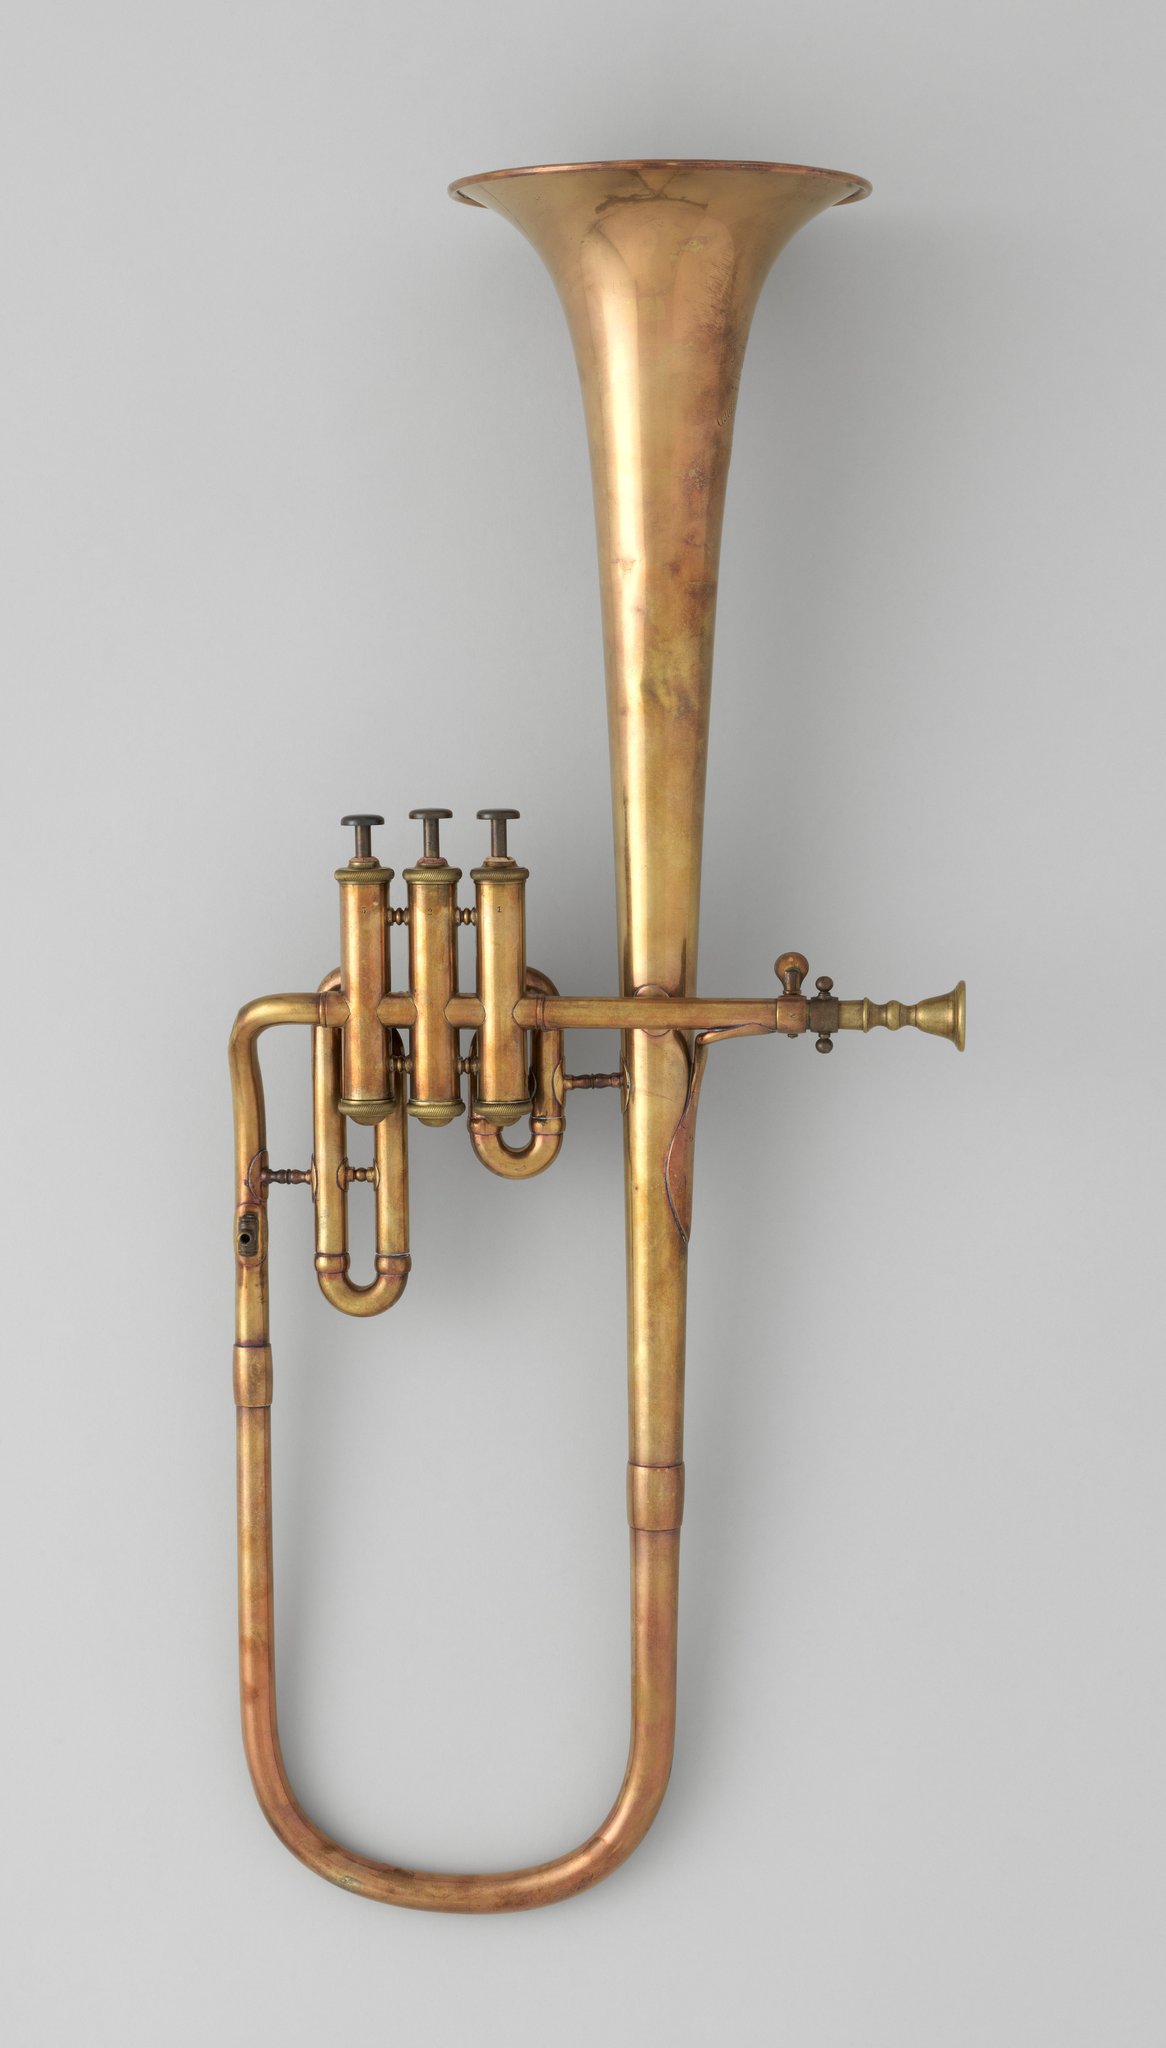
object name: soprano saxhorn in b flat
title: Alto Saxhorn in B-flat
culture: french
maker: gautrot aîné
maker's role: maker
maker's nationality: french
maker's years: 1870-1884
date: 1900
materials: brass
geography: france